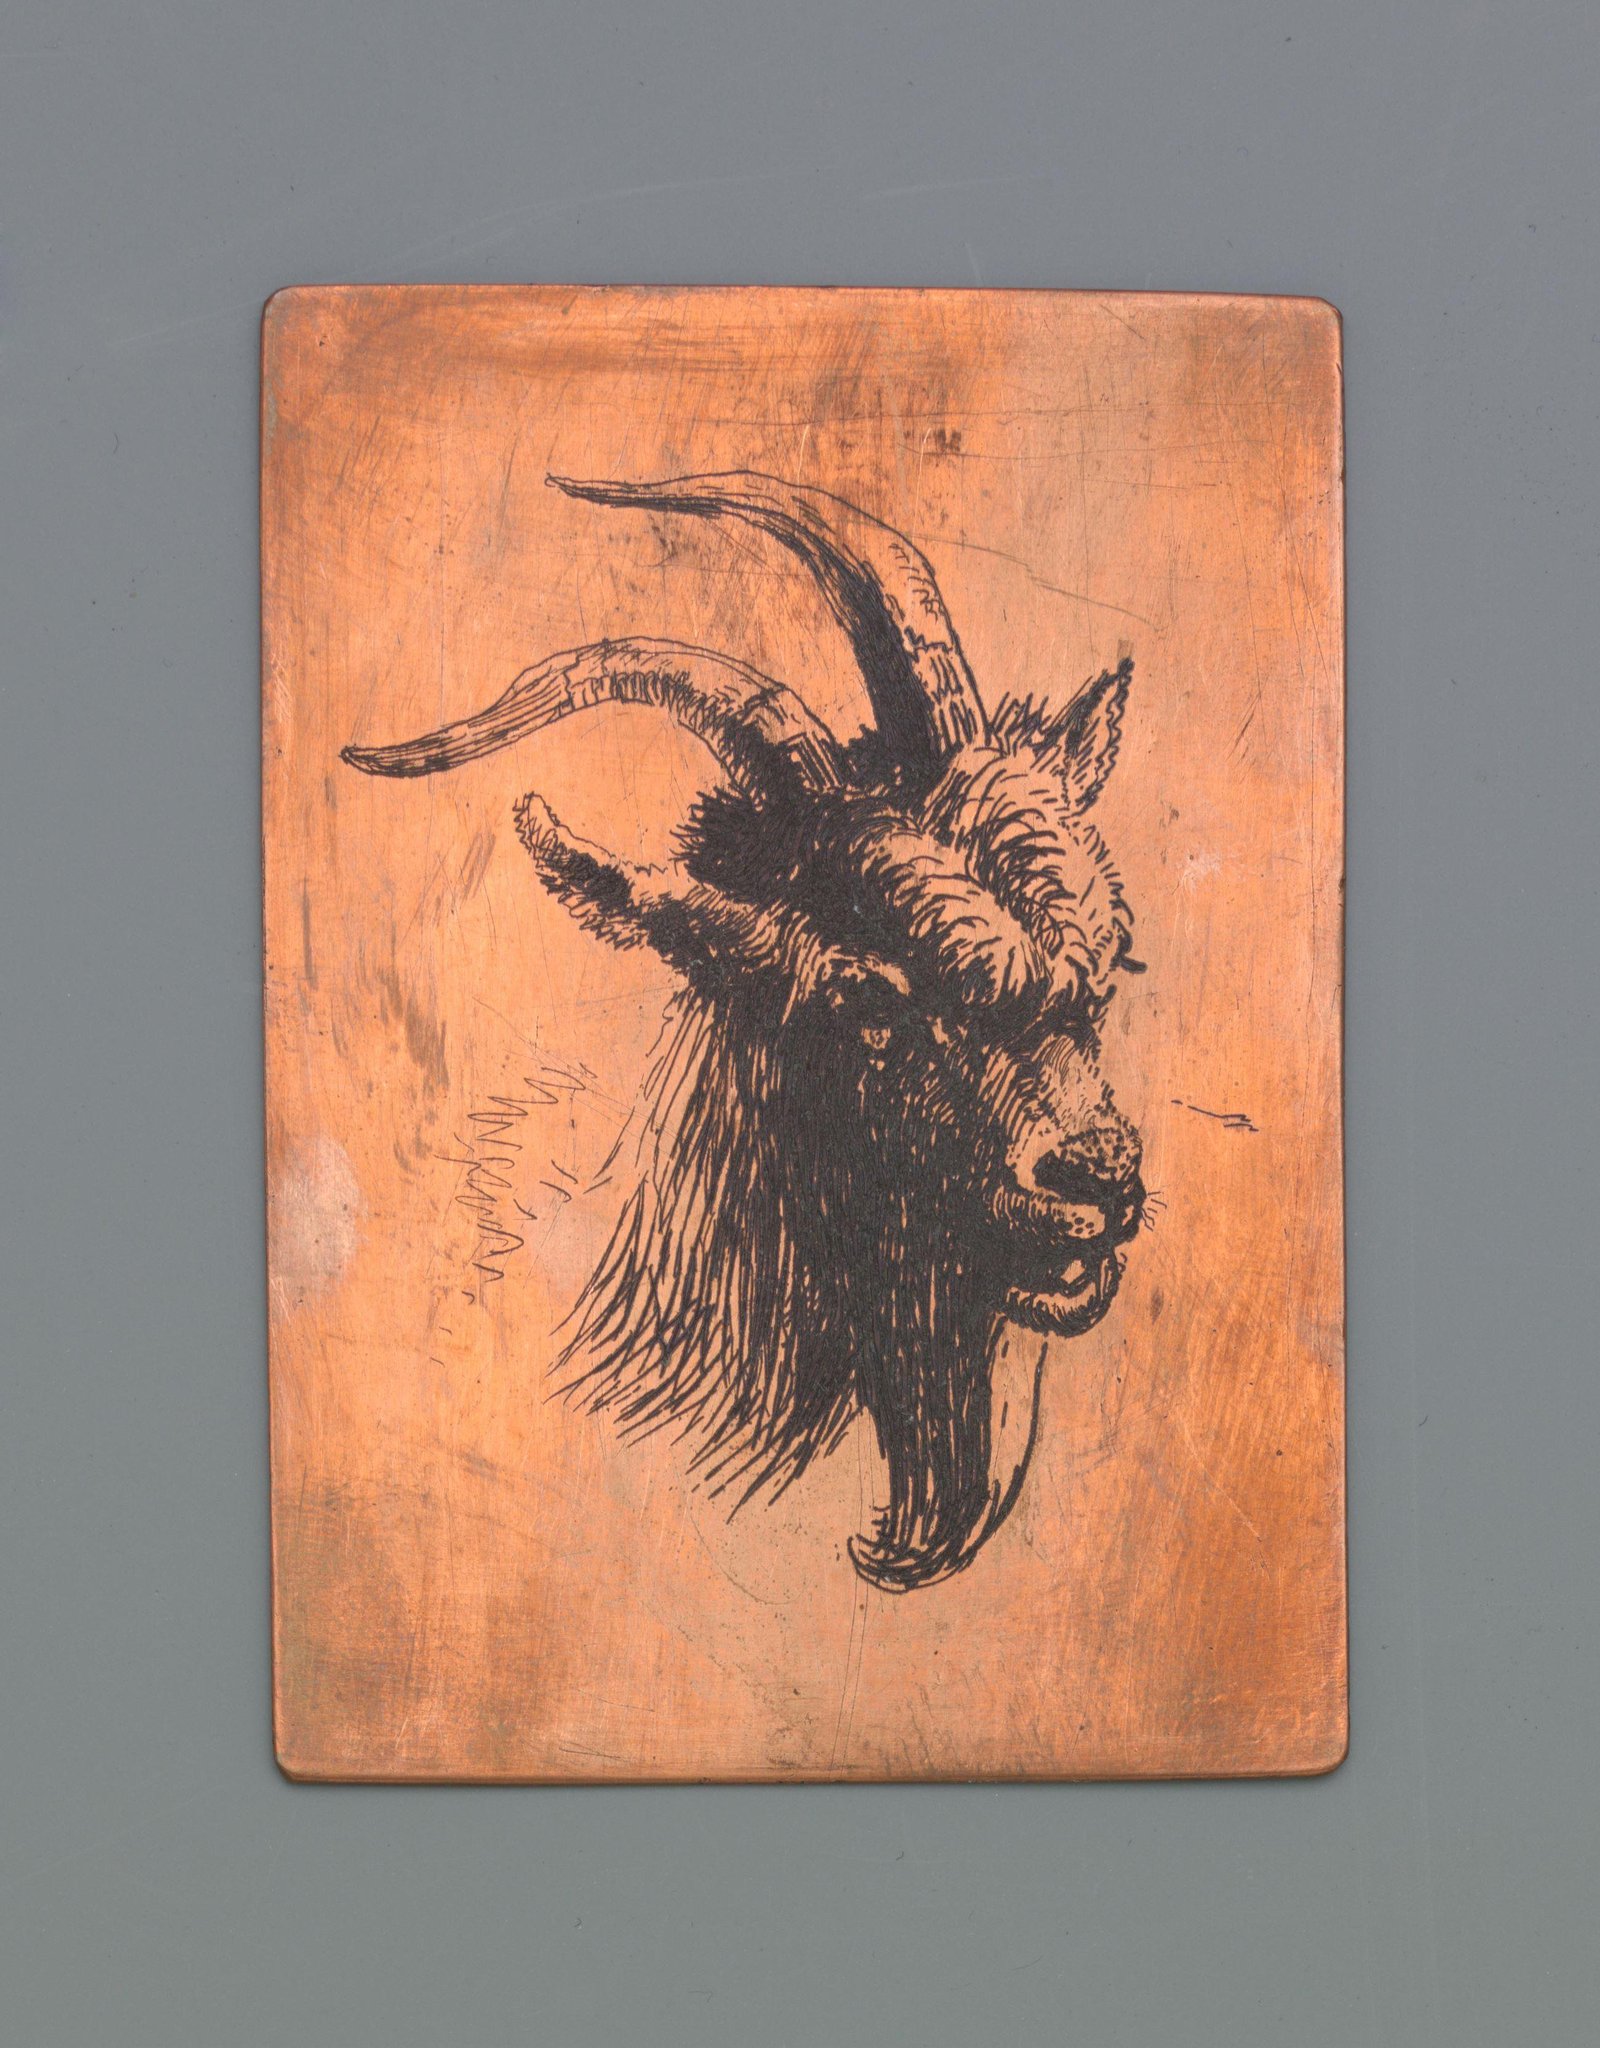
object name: copper plate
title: Kop van een bok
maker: jacob maris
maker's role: draughtsman, painter, print maker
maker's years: 1837-1899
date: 1847-1899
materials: copper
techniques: etching